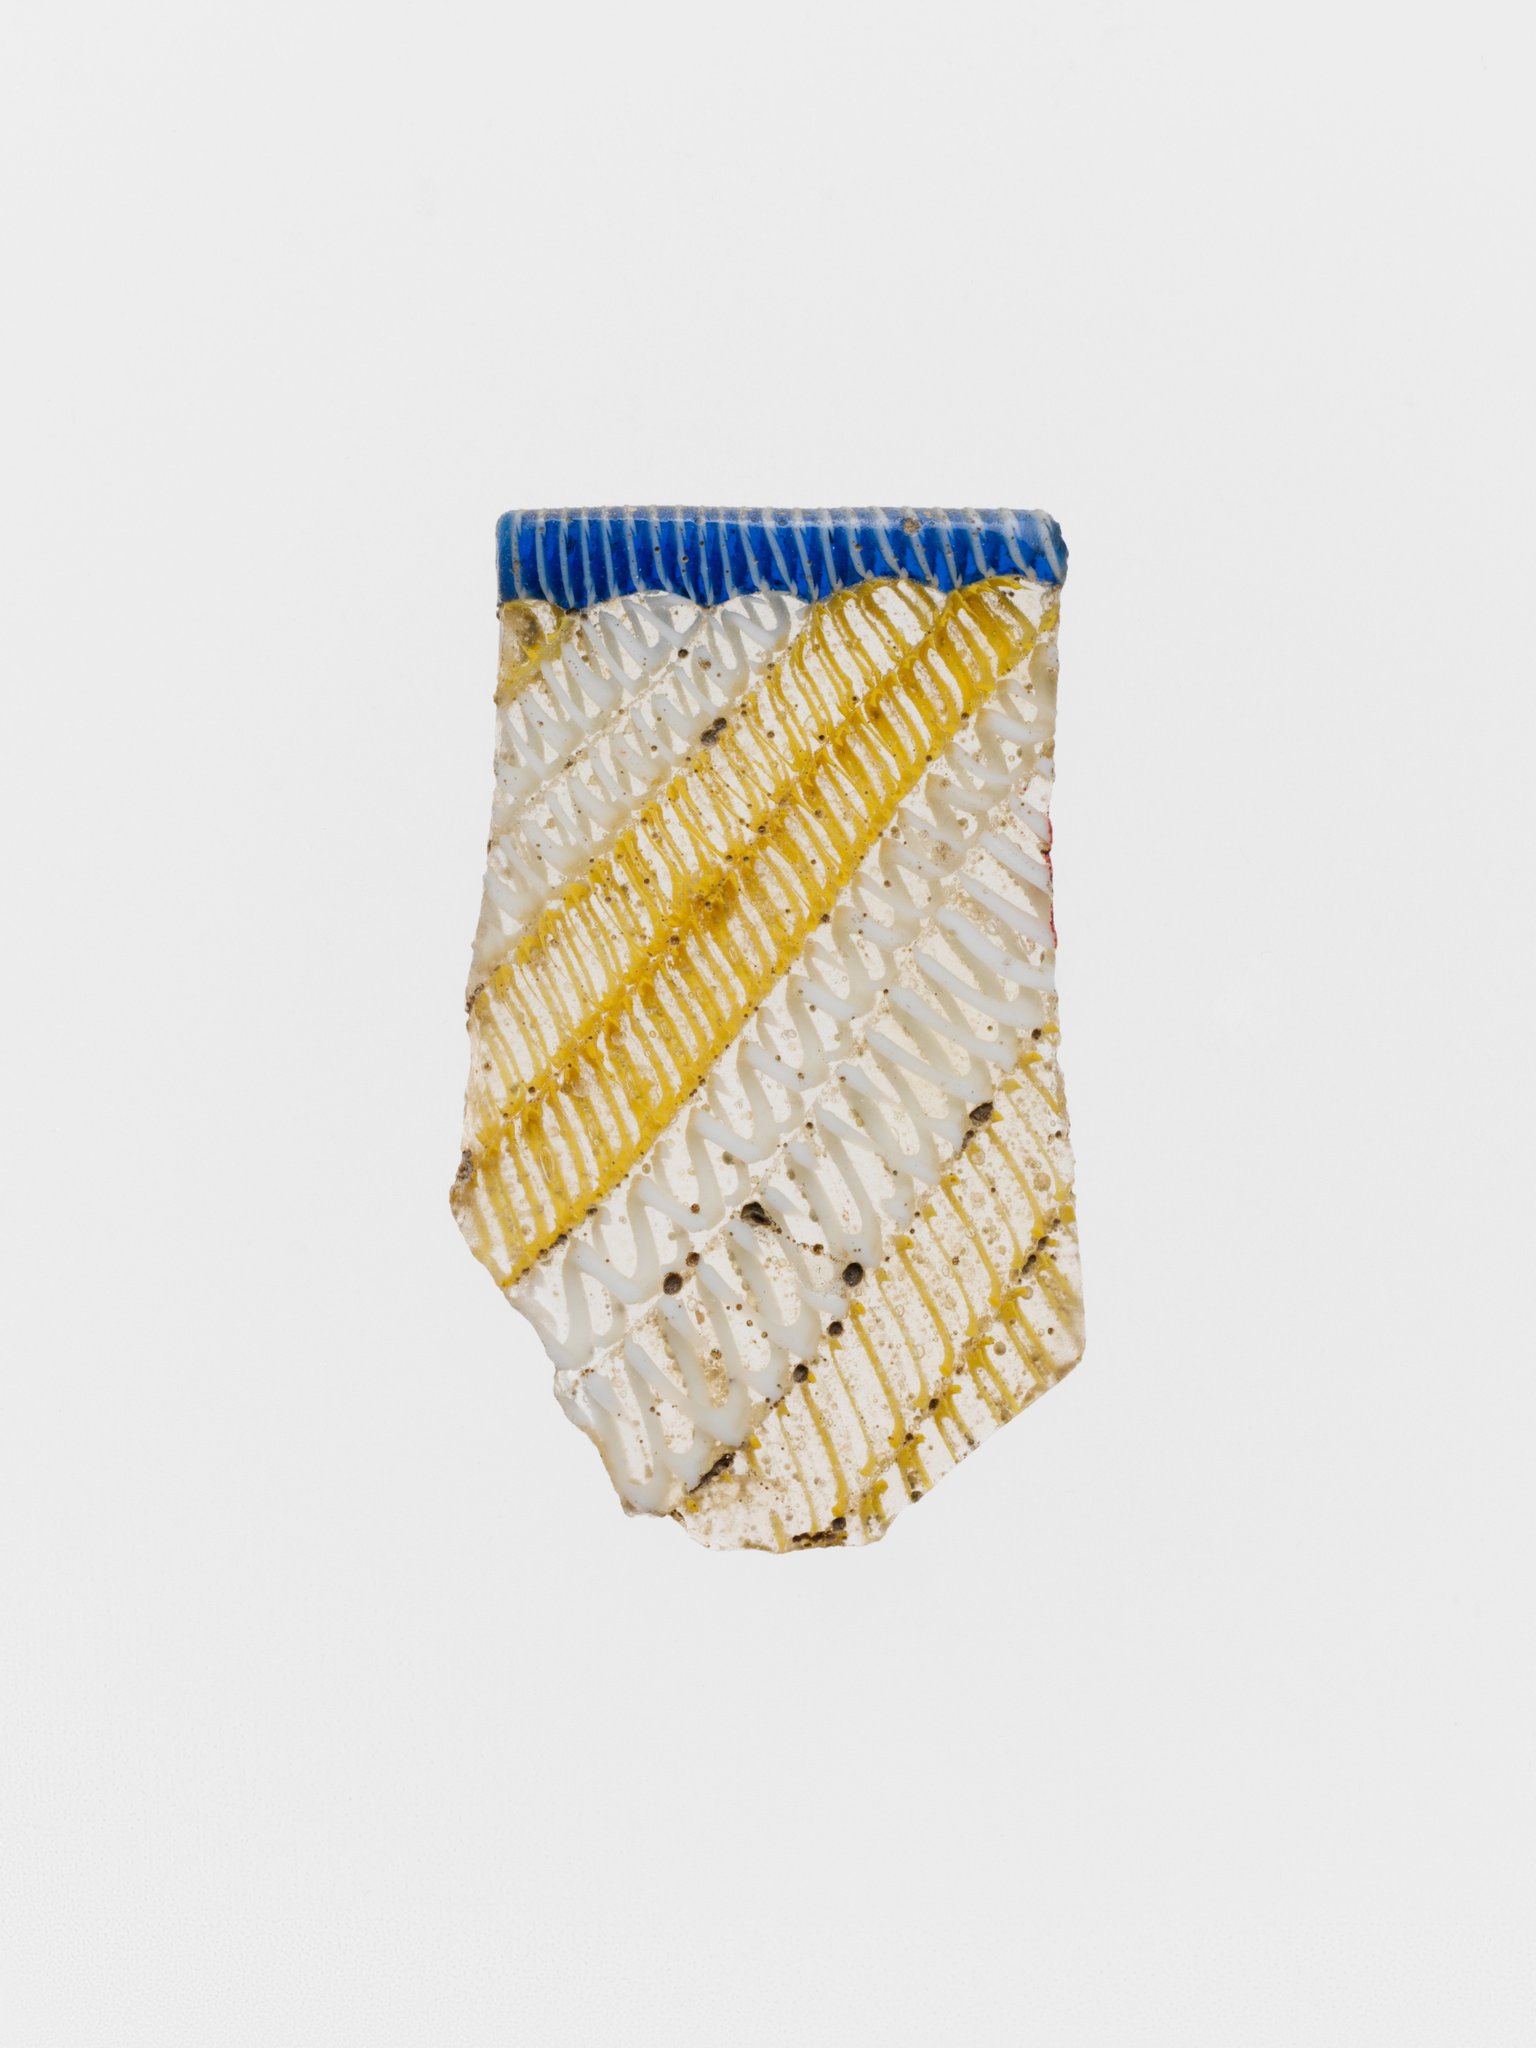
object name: fragment, mosaic bowl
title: Glass network mosaic bowl fragment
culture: roman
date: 34 BCE-33 CE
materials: glass